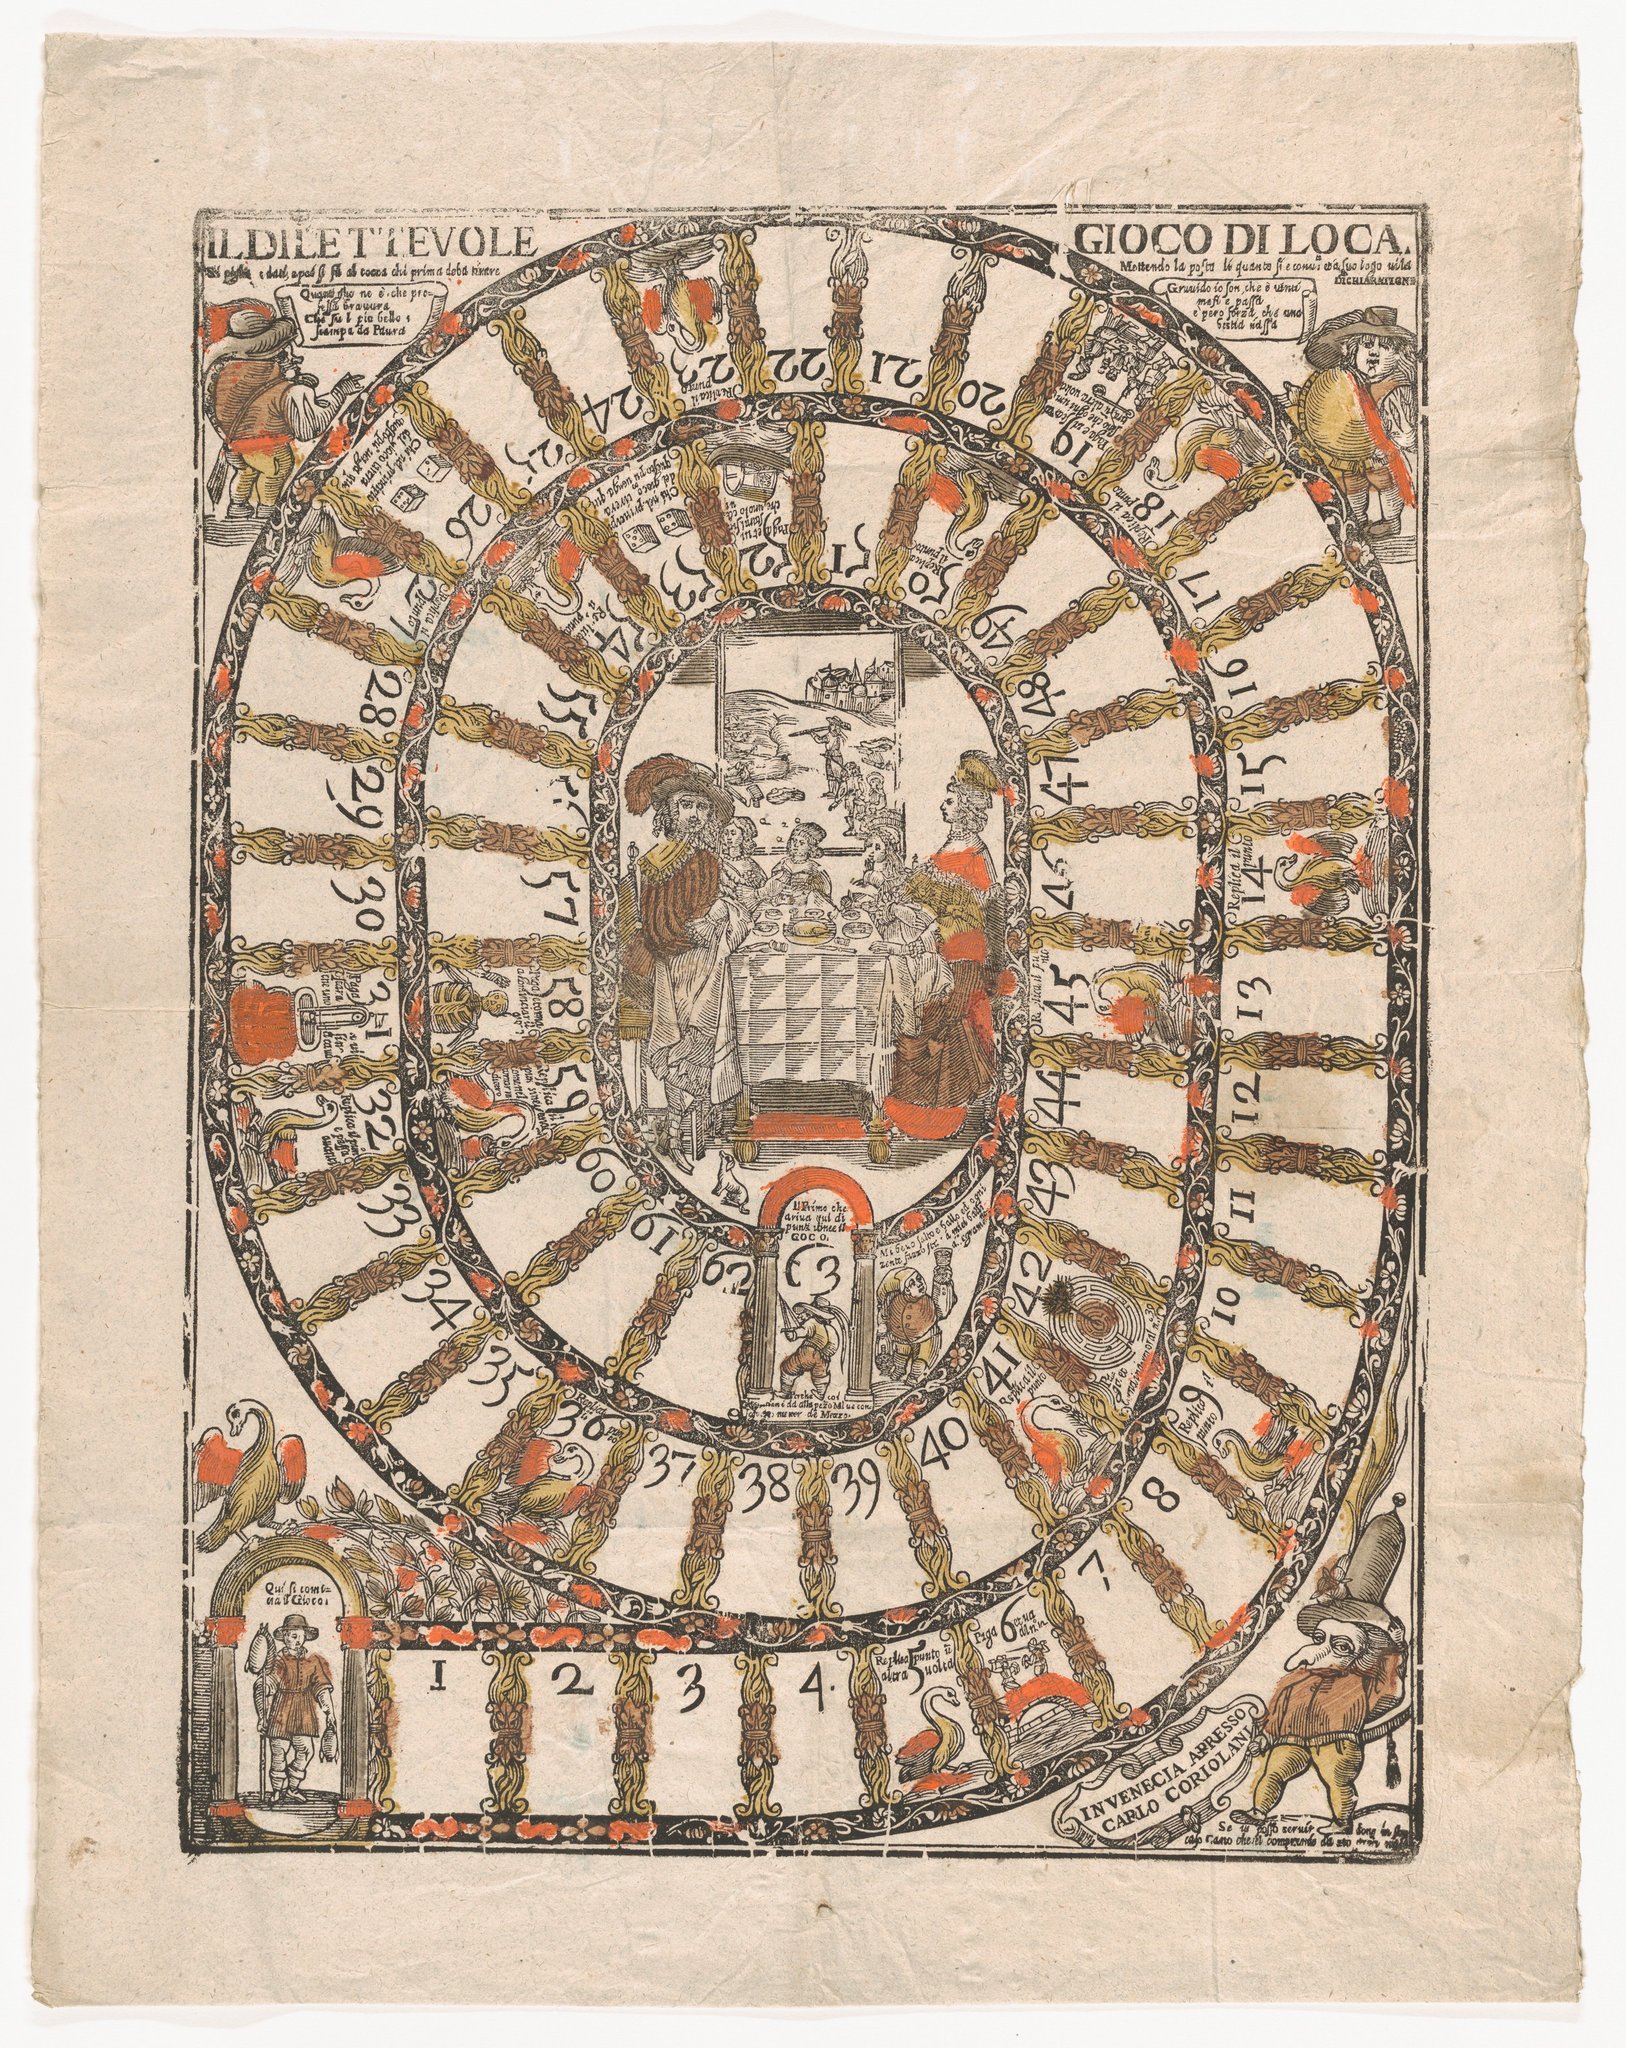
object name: print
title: The Pleasant Game of the Goose (Il Dilettevole Gioco di Loca)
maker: Anonymous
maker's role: artist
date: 1640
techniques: hand coloring, woodcut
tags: games